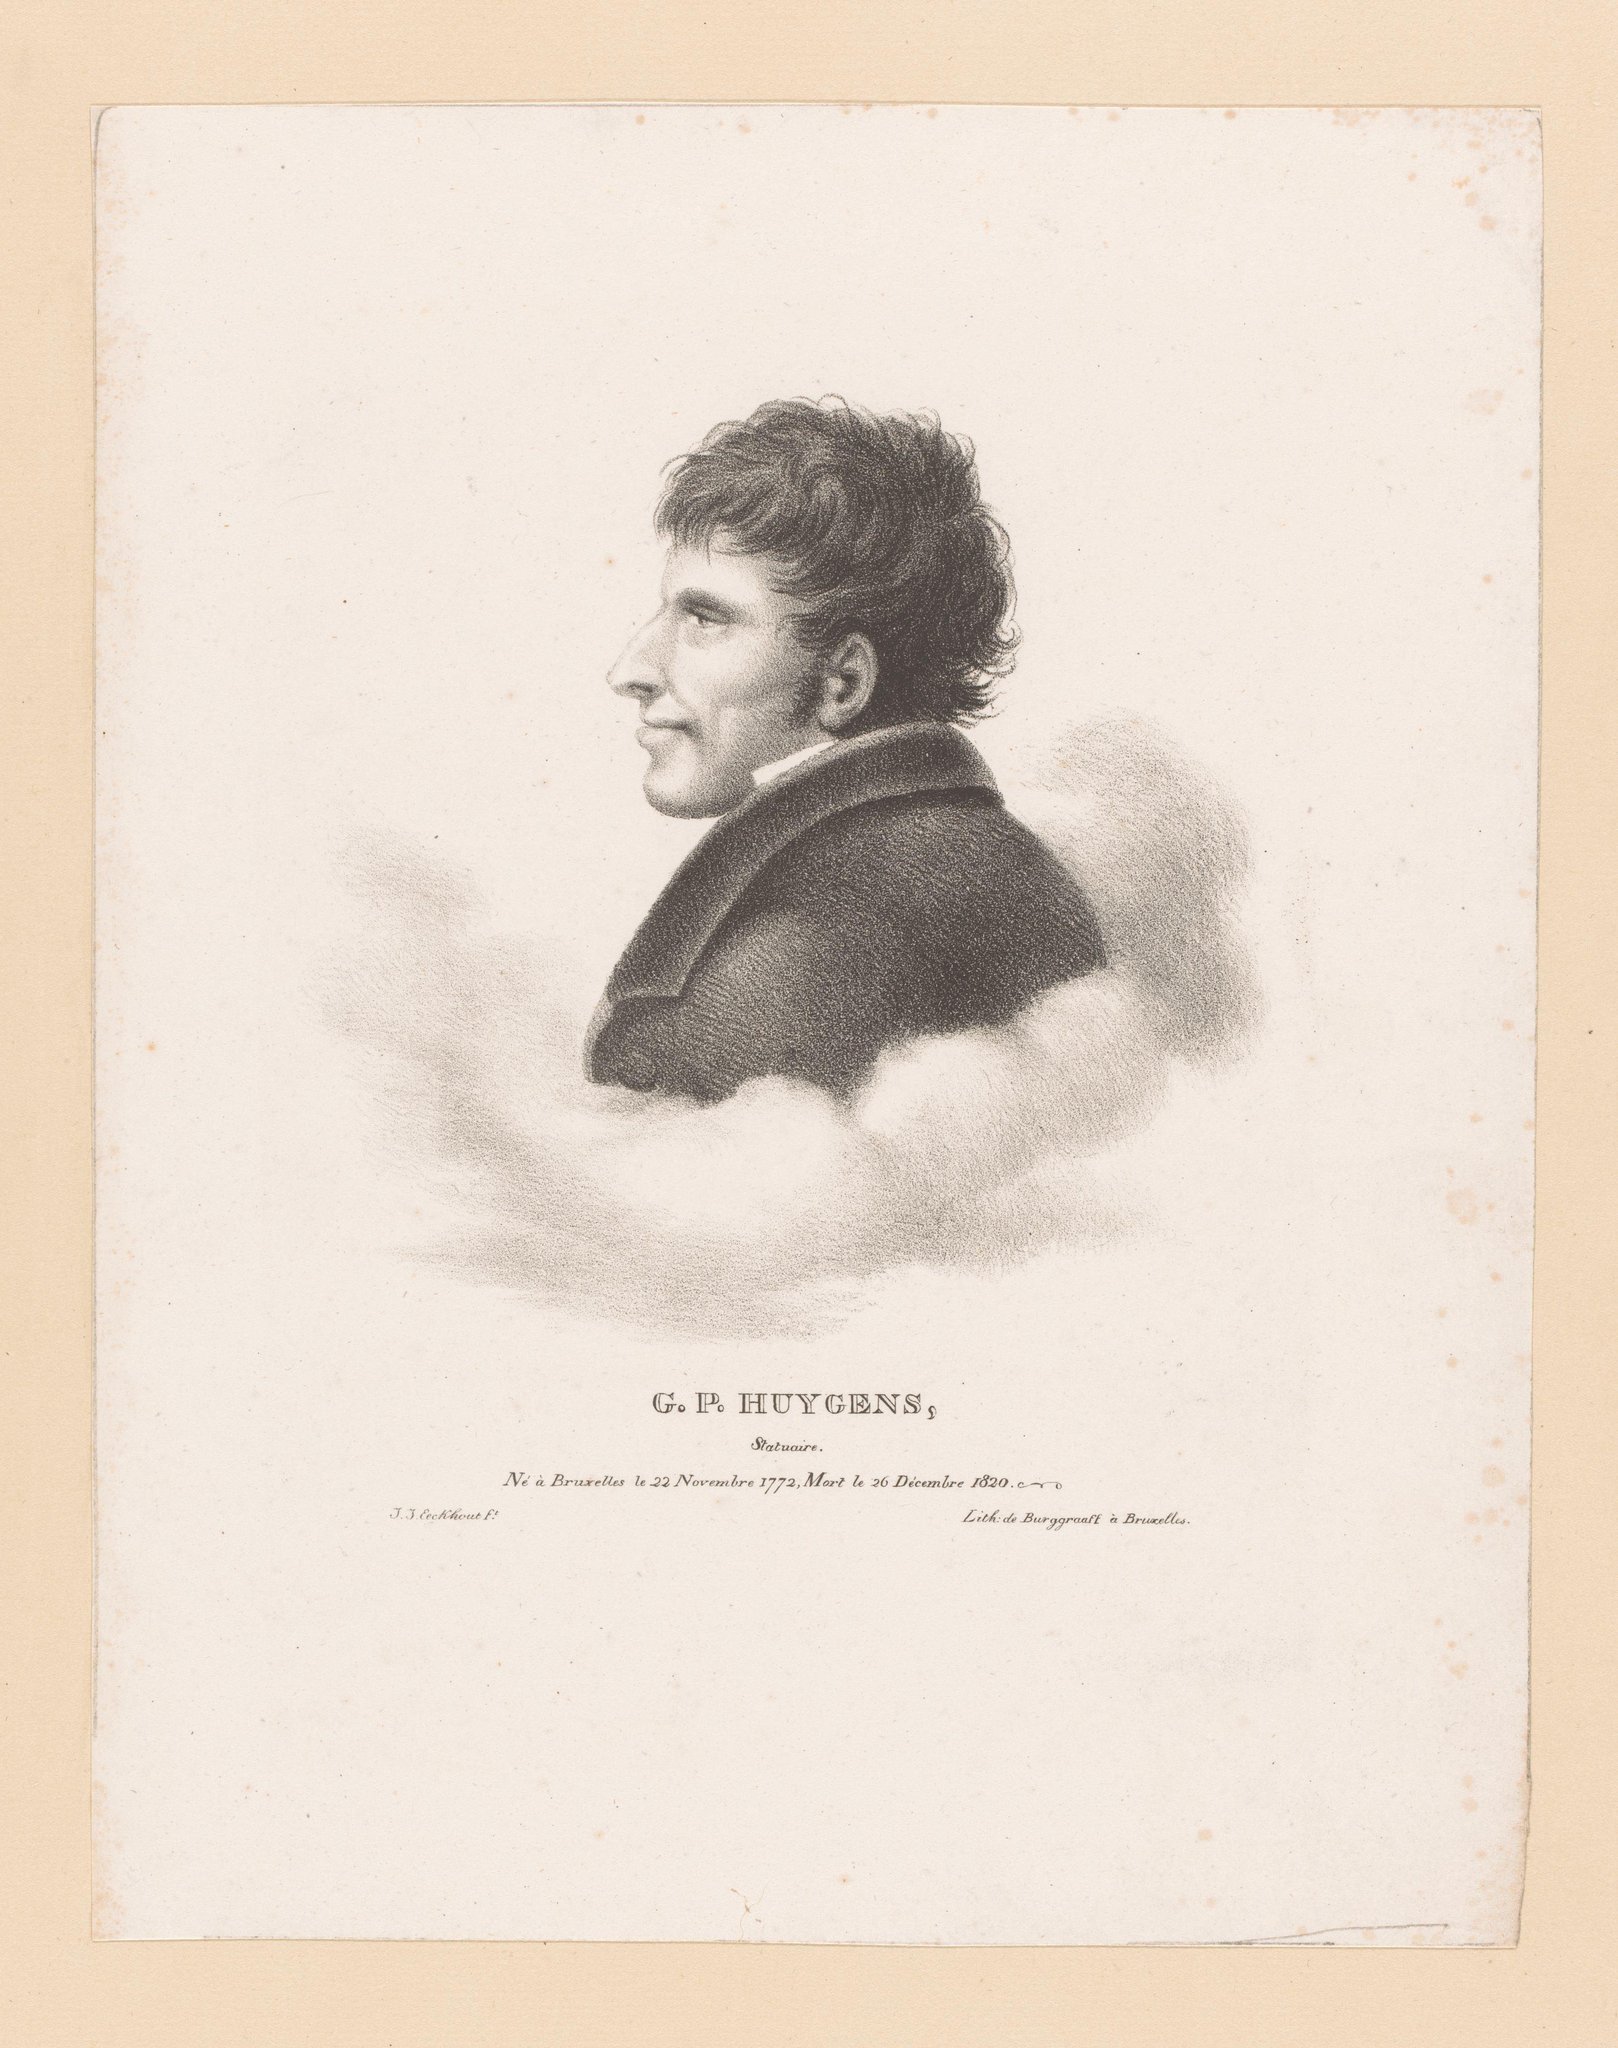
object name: print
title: G.P. Huygens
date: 1822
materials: paper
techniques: lithograph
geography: brussels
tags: portrait, self-portrait of sculptor, historical persons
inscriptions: collector's mark: Lugt 2228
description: Prent maakt deel uit van een serie van zestig prenten.